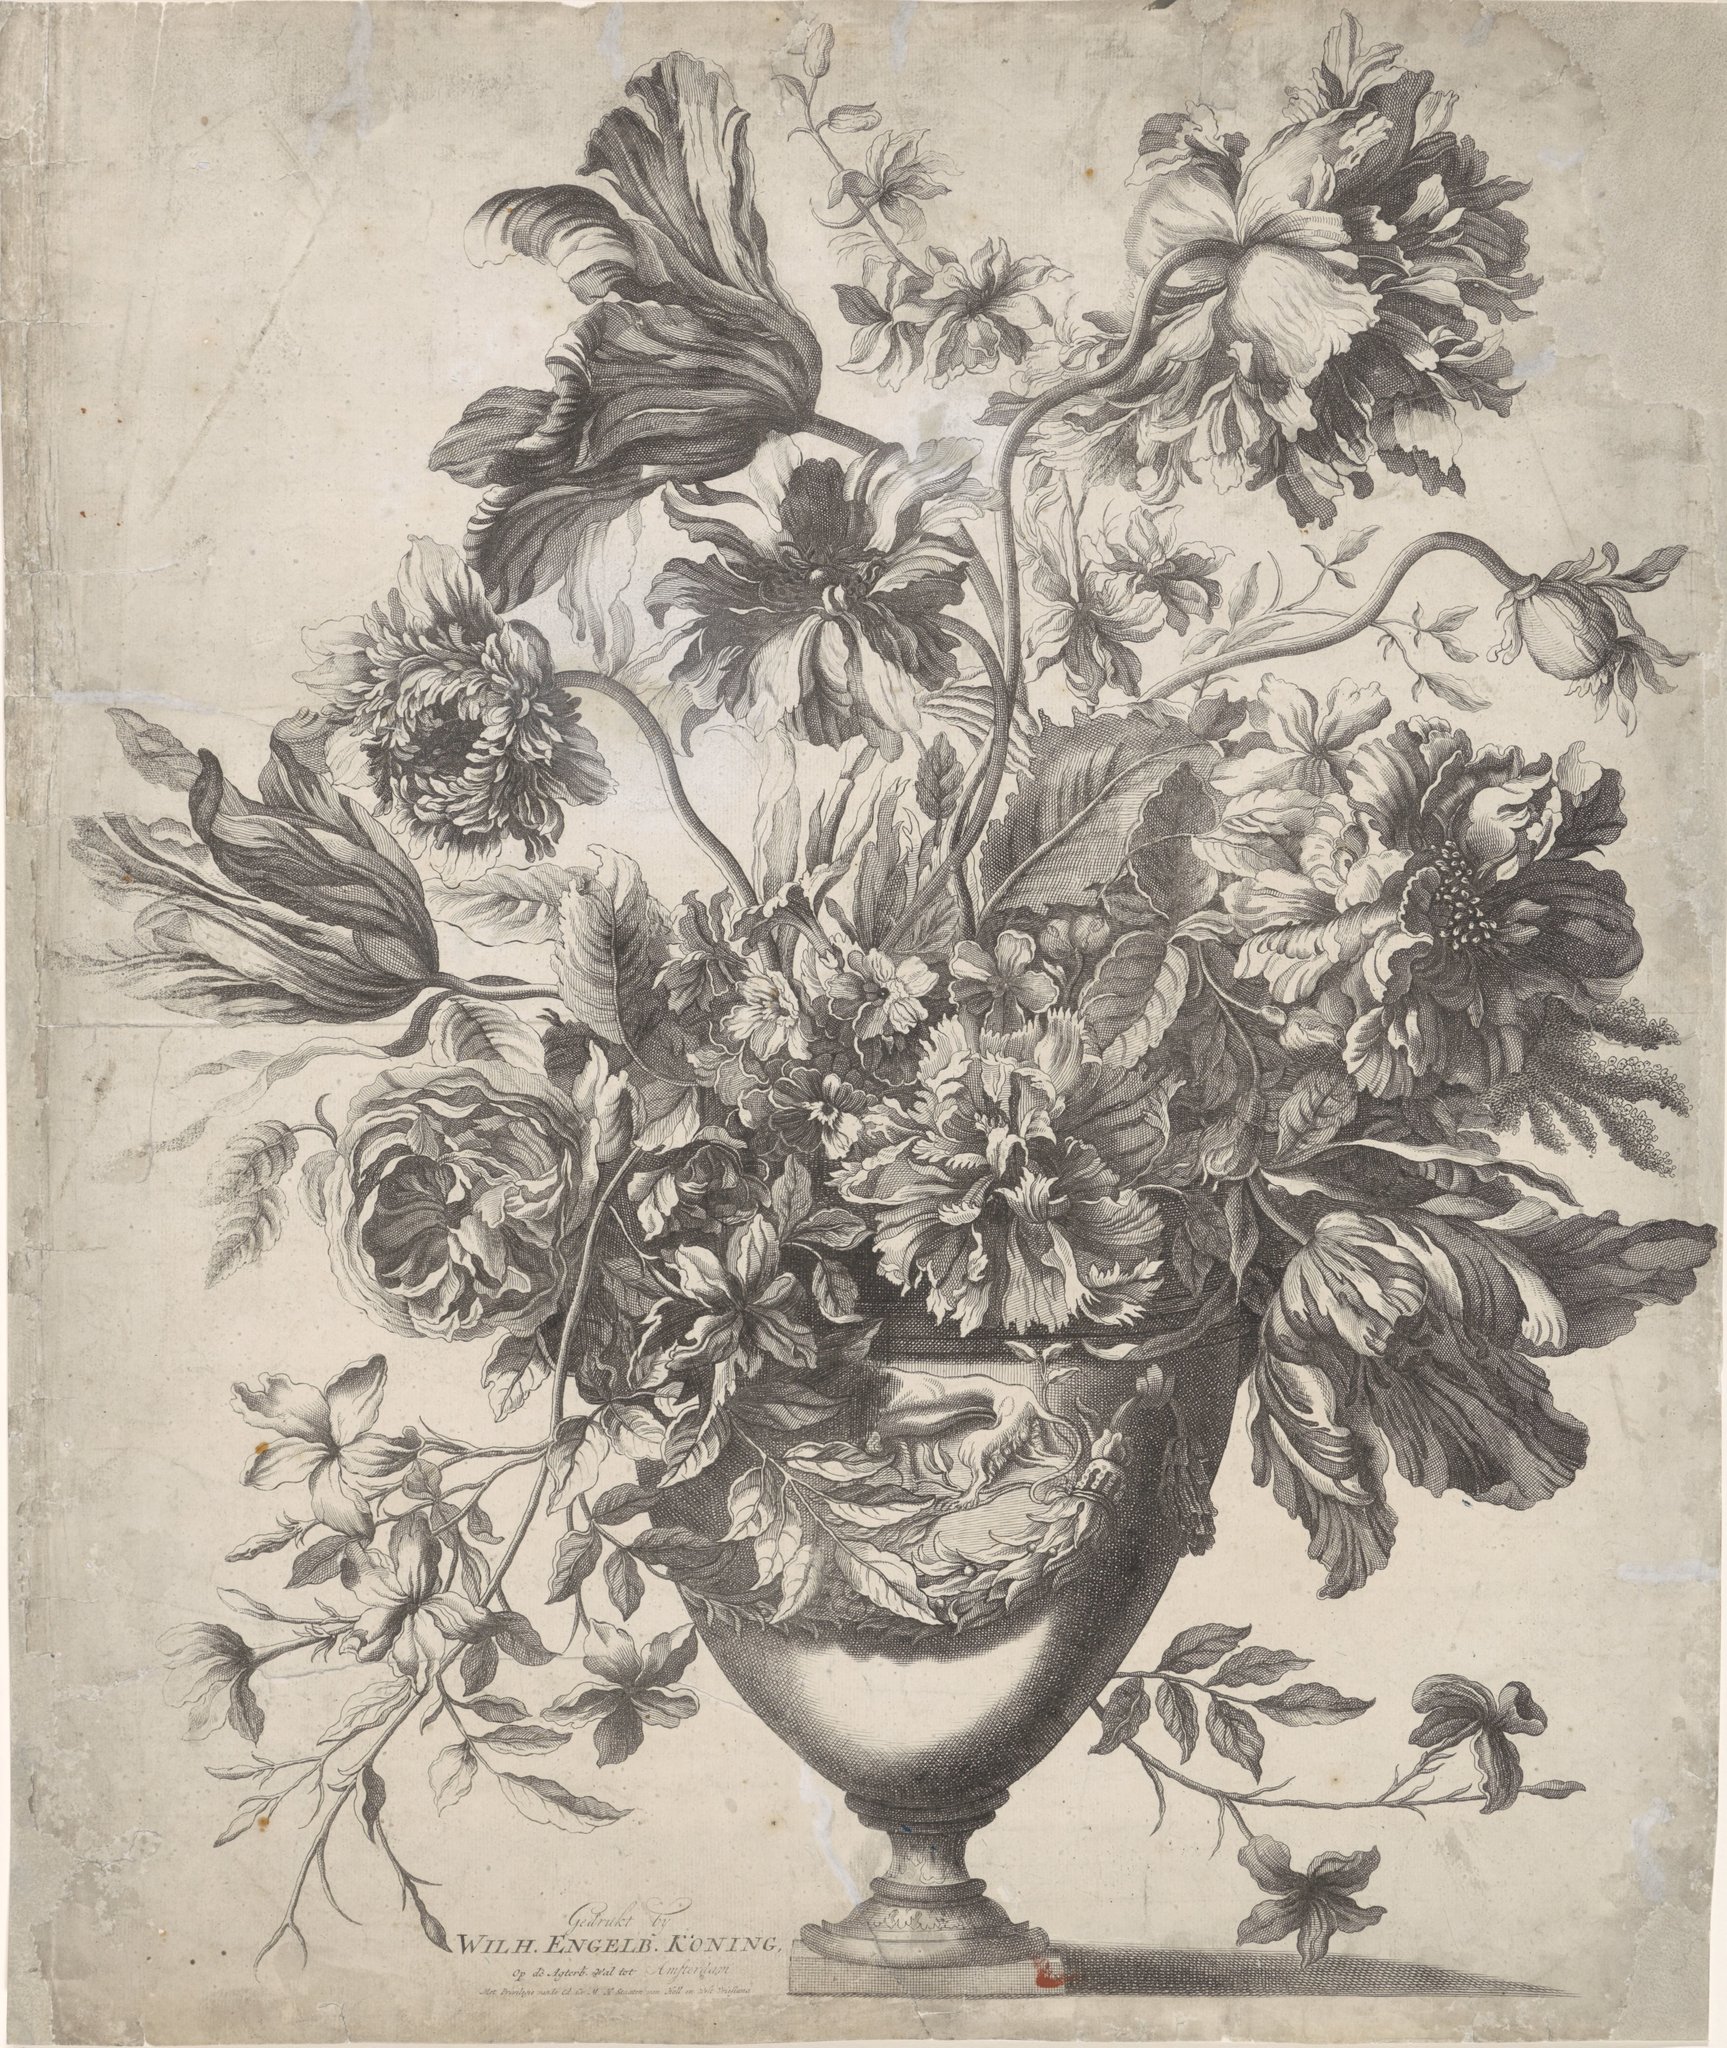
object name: print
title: Stenen vaas met bloemen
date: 1717-1732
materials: paper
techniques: engraving, etching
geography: amsterdam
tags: flowers: tulip, flowers in a vase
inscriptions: collector's mark: Lugt 2228, collector's mark: Lugt 2760, address: ‘Gedrukt bij / Wilhelm. Engelb. Köning / op de Agterb. Wal tot Amsterdam / met privilege van de Ed. Gr. M.H. Graven van Holland’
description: Vergelijk bloemenvazen van L. Schenk, P. Schenk en P. Mortier exc.